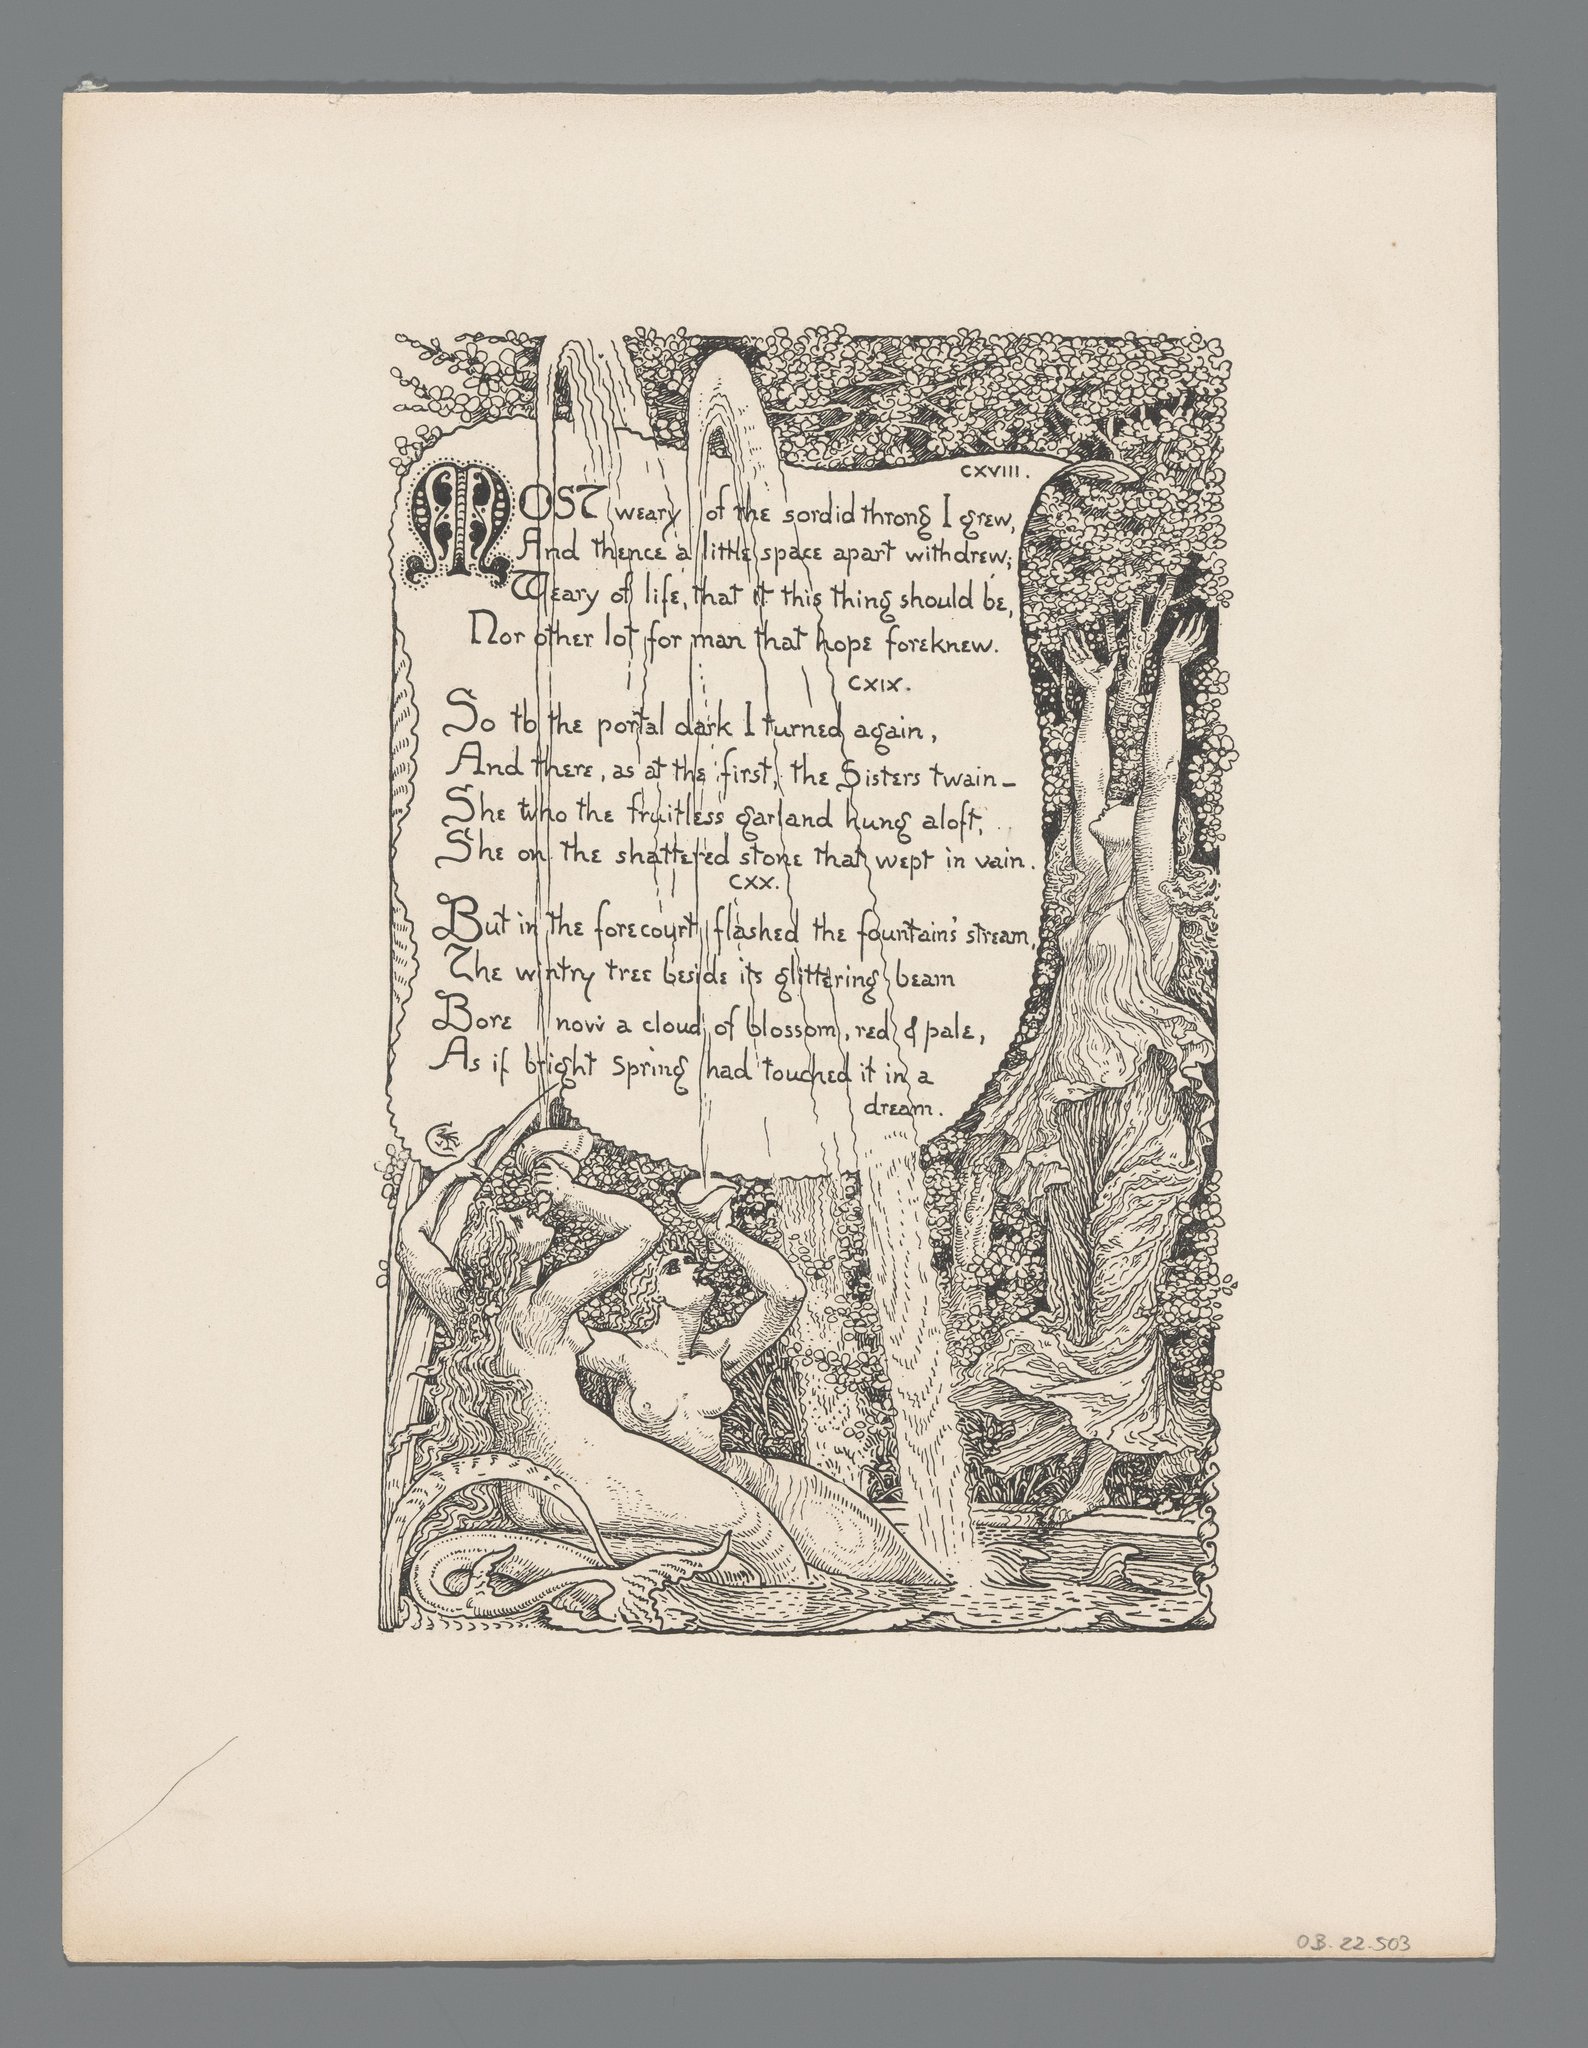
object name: print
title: Cartouche met twee zeemeerminnen en een vrouw met opgeheven armen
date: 1886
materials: paper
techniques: engraving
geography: london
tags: adult woman, merman - aa - mermaid, siren, water course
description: Prent uit: Crane, Walter. The sirens three. Londen: Macmillan & Co., 1886.